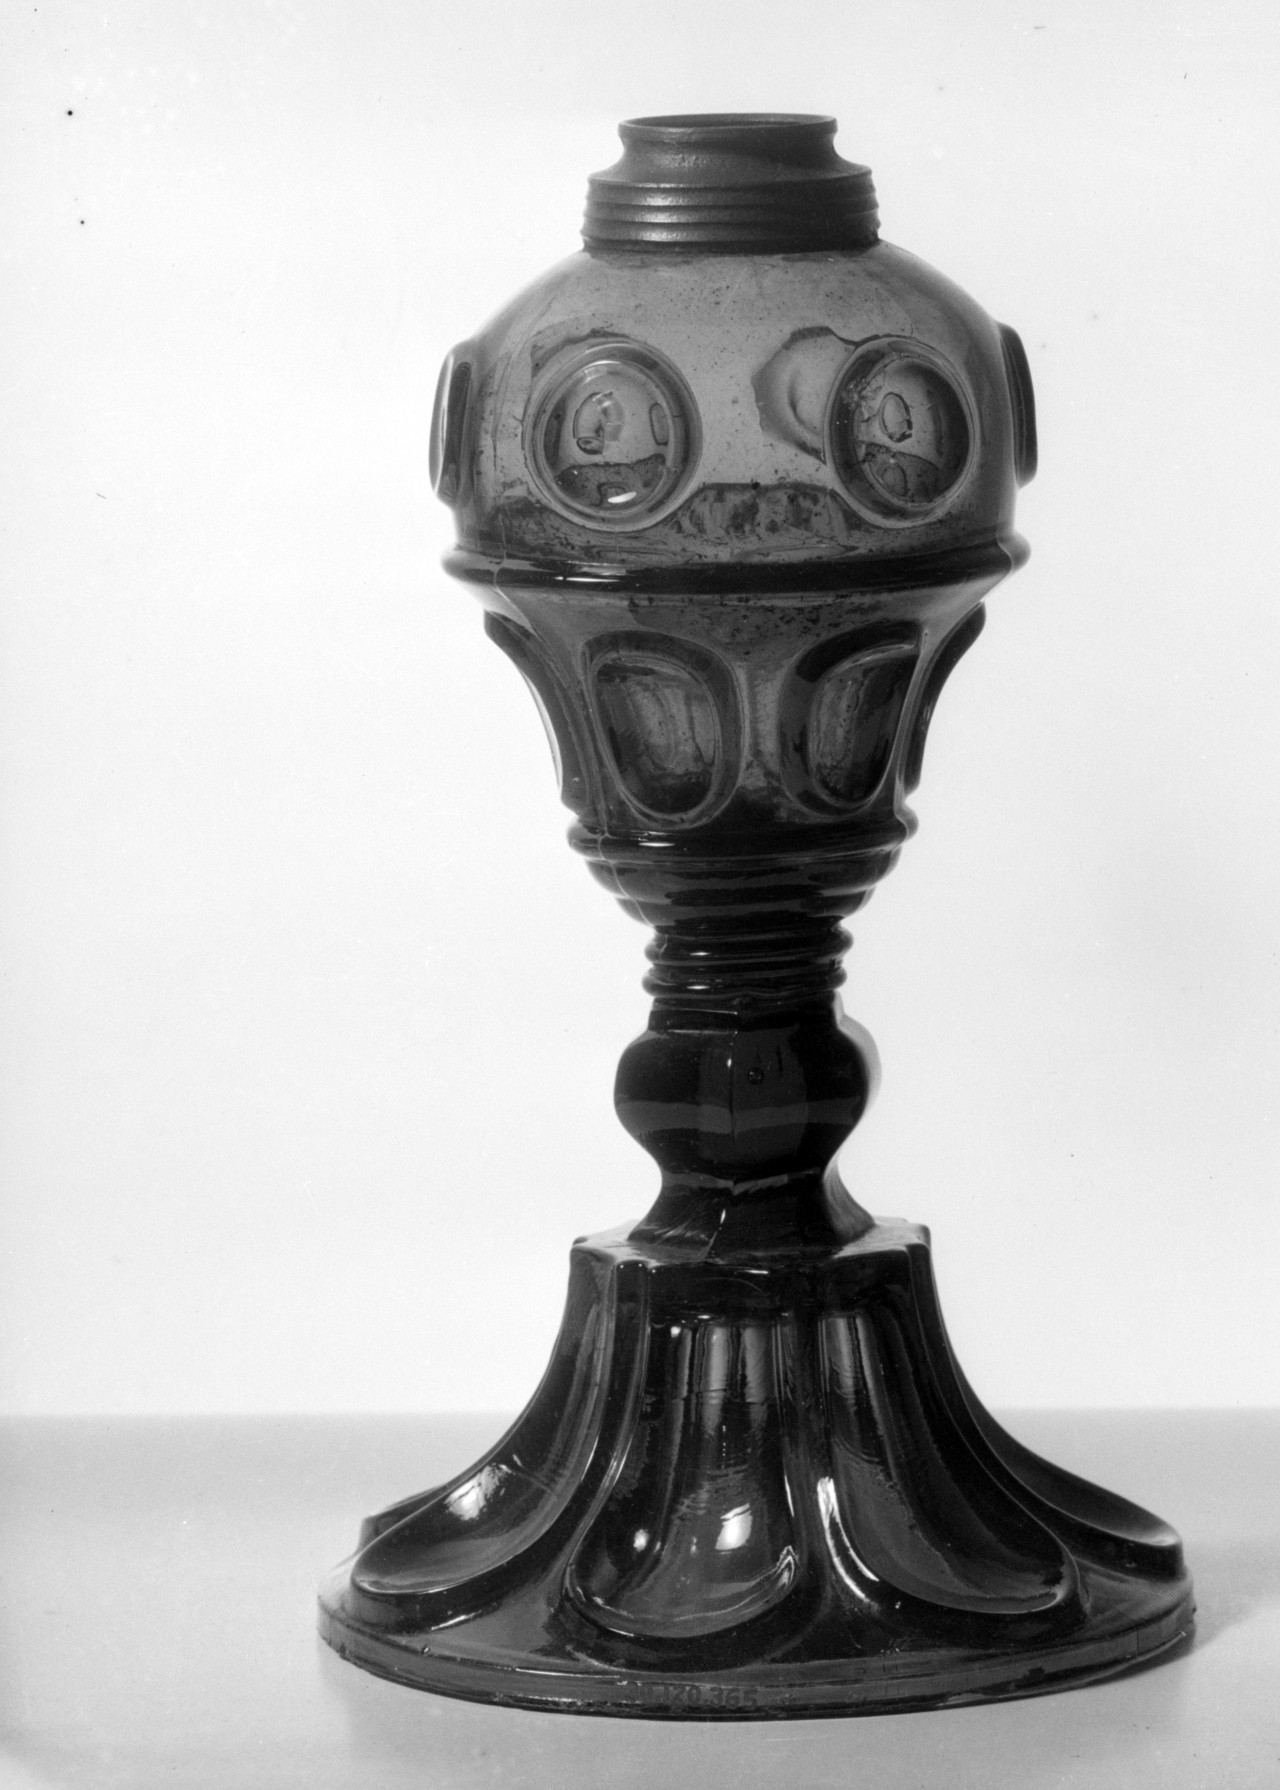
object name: oil lamp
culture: american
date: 1830-1900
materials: gemstone, glass, metal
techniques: pressed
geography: united states